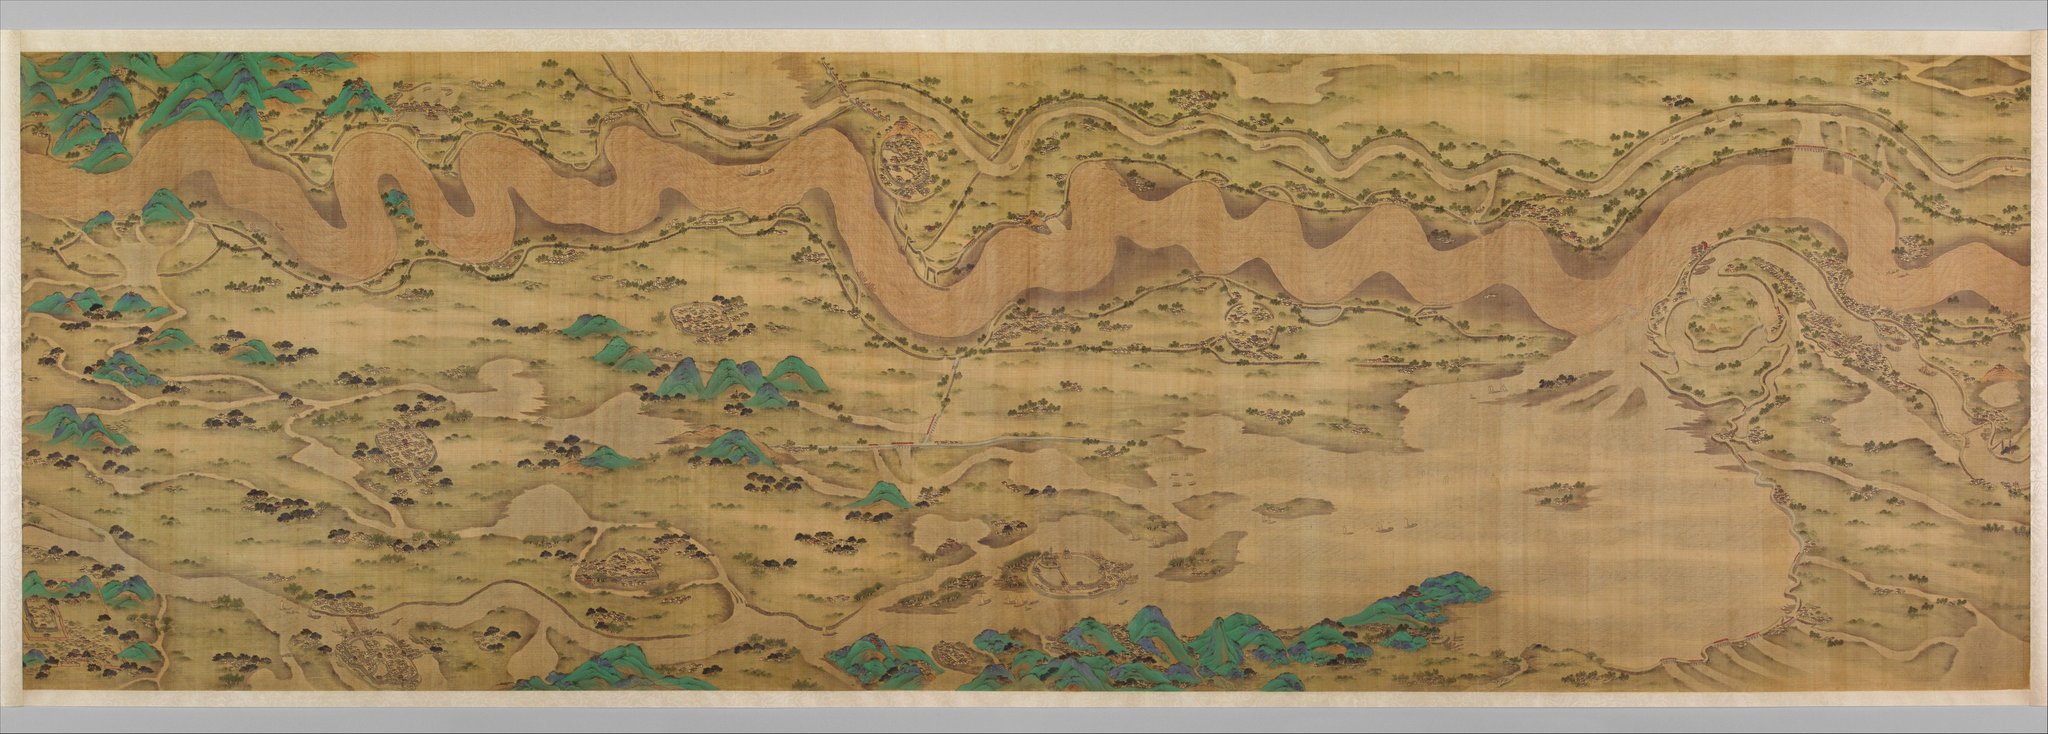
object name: handscroll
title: Ten Thousand Miles along the Yellow River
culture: chinese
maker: unidentified artist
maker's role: artist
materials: gold, ink, silk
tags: rivers,maps